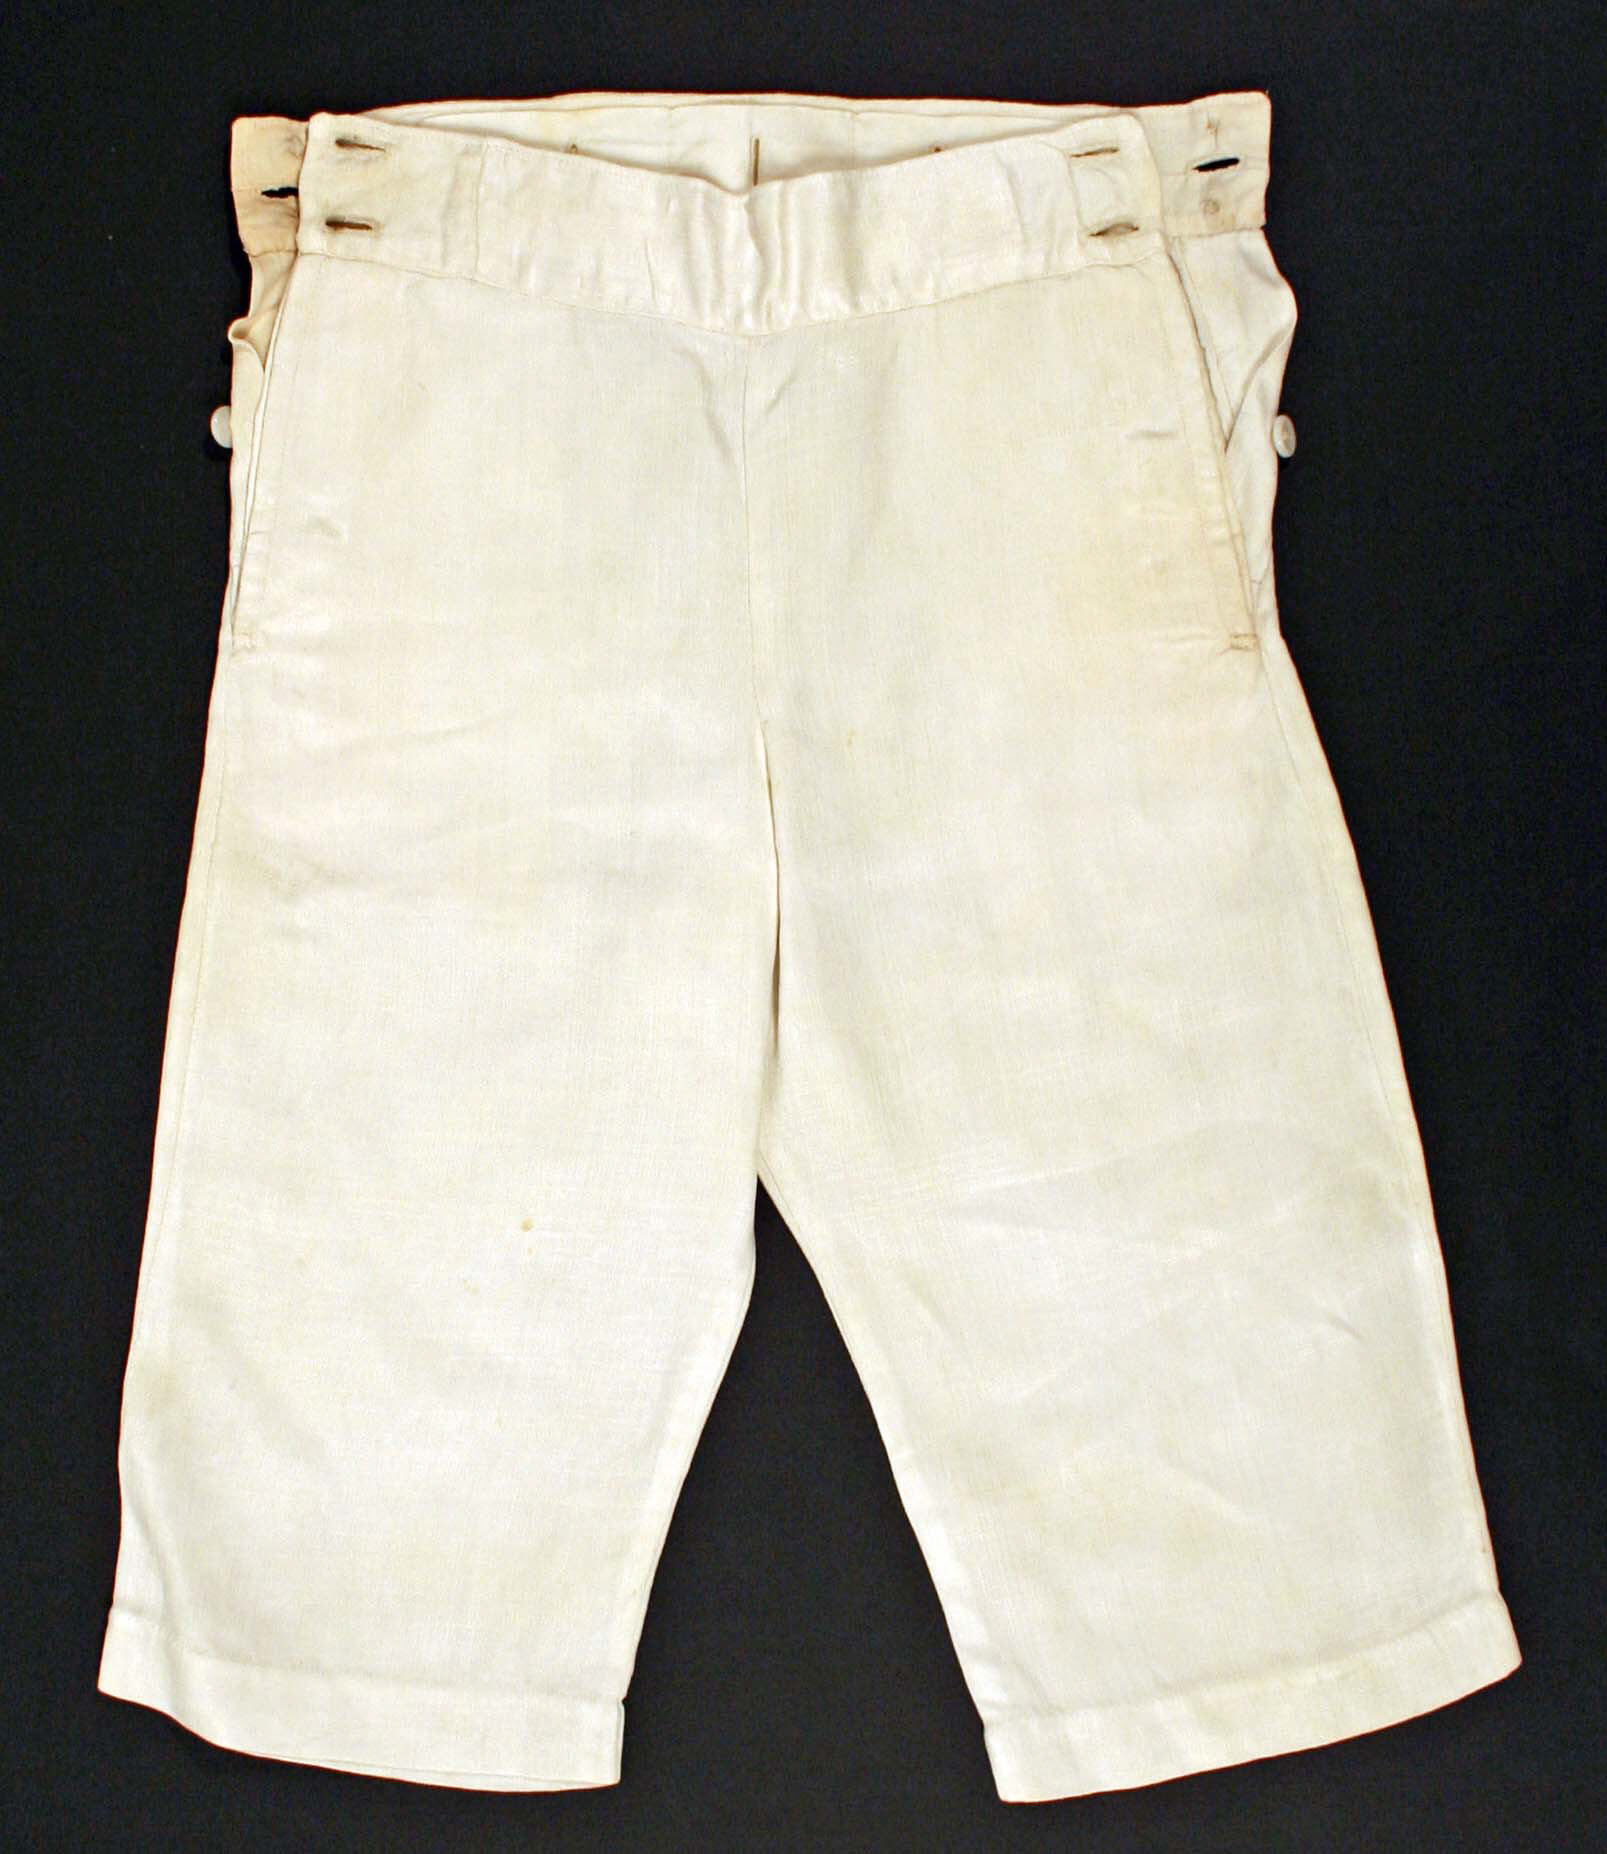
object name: trouser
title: Trousers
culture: american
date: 1800-1850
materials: cotton